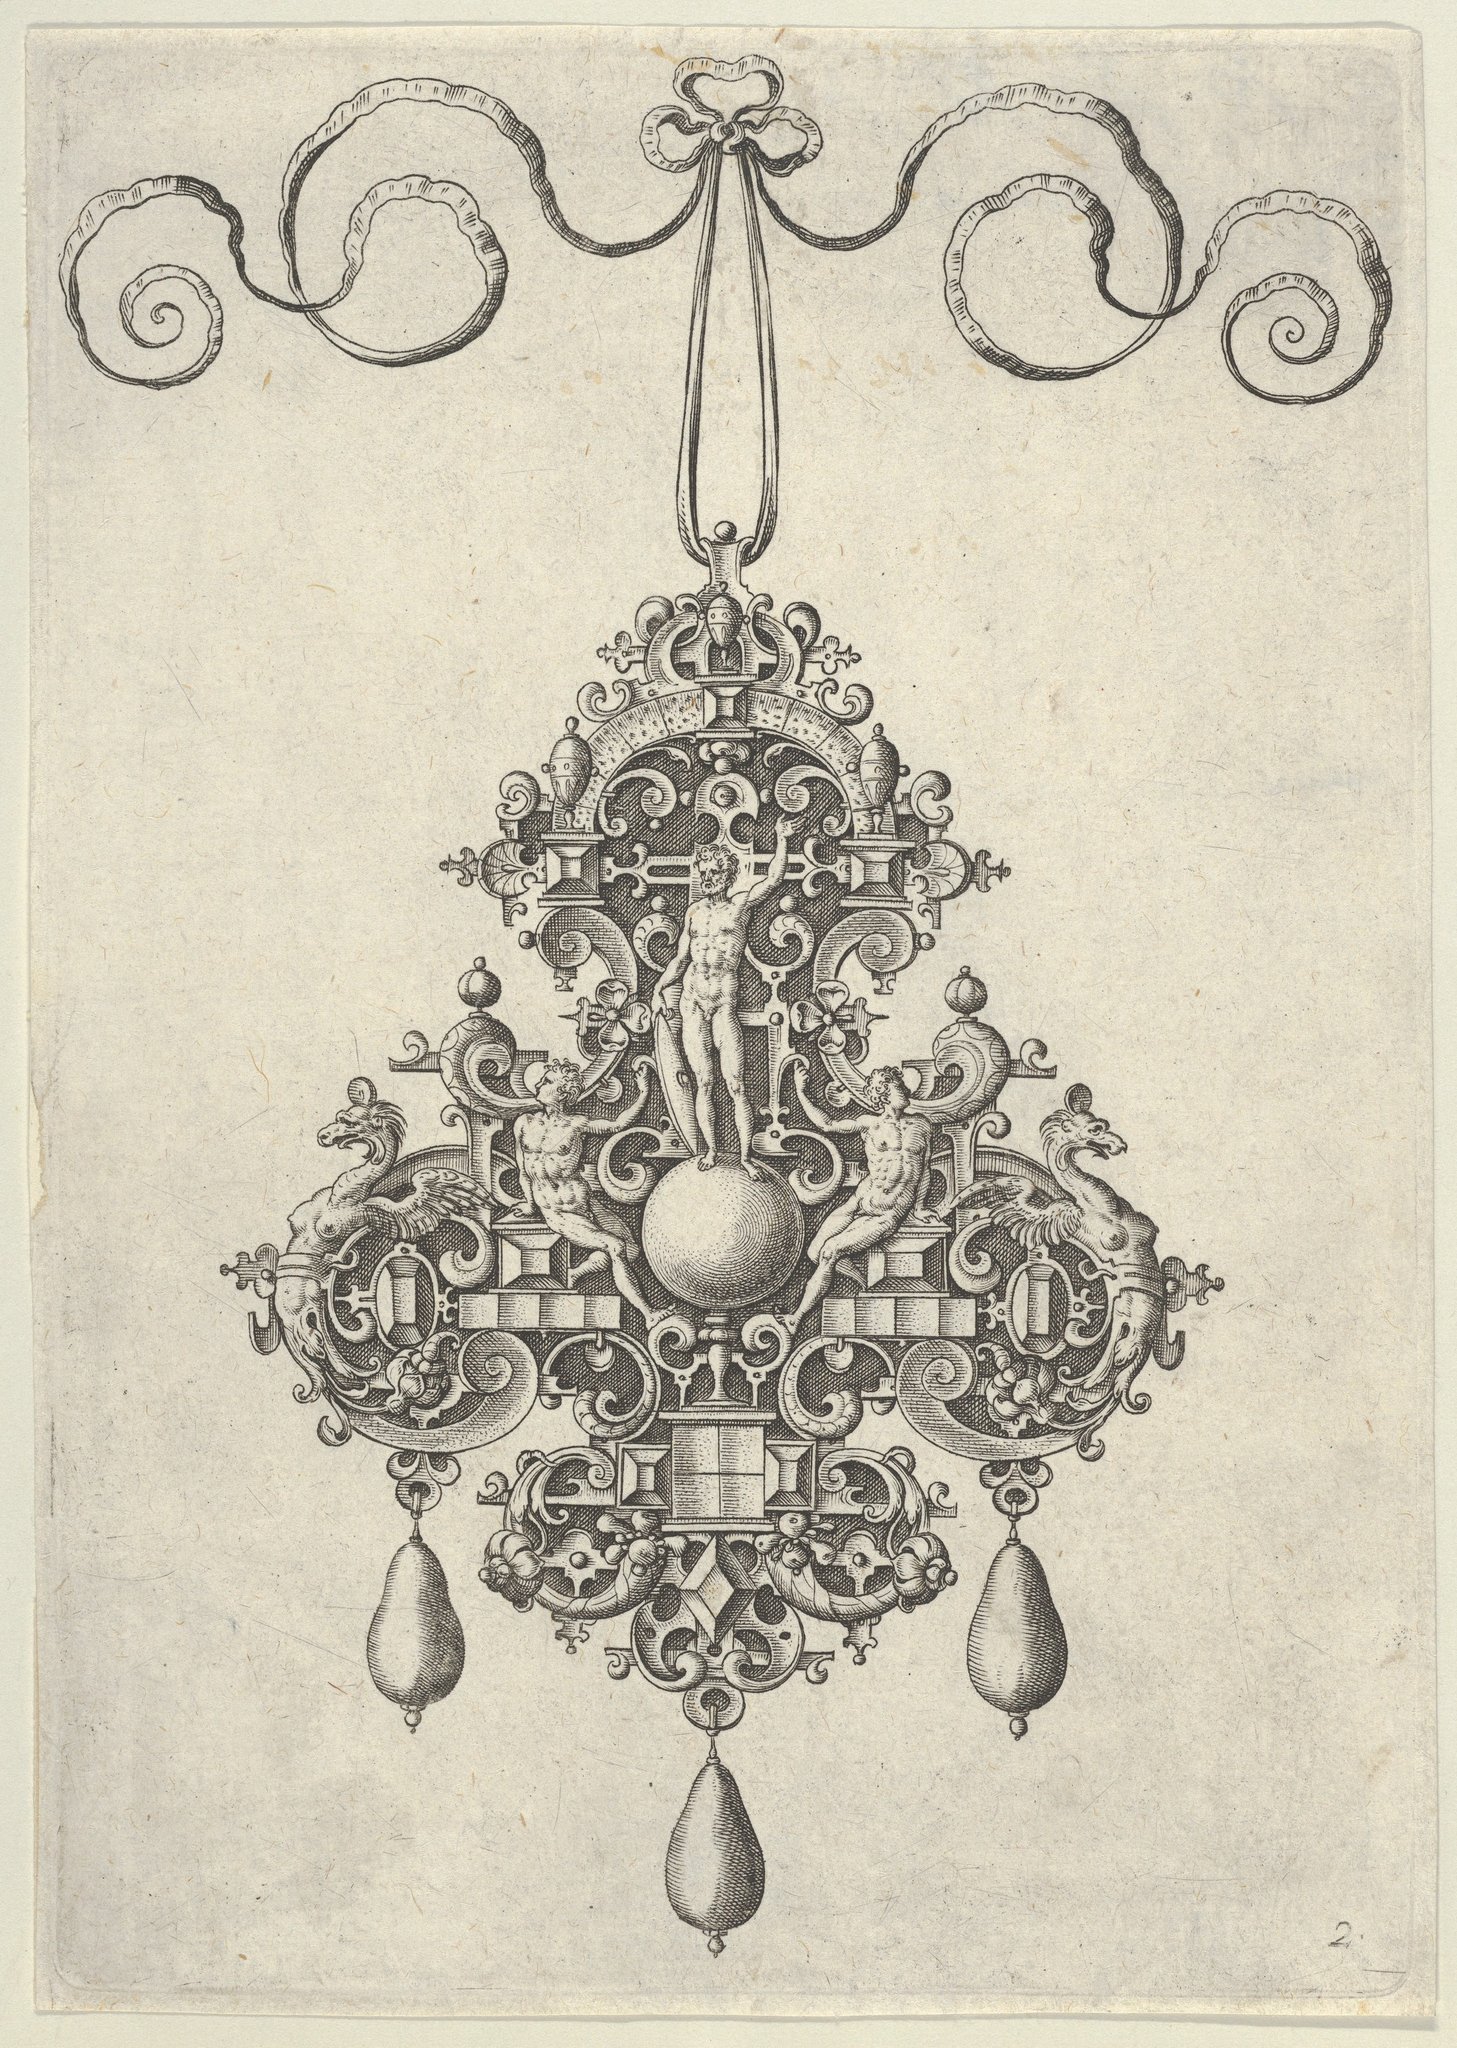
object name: print ornament architecture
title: Pendant Design with a Male Diety with a Shield Flanked by Two Reclining Men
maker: jan collaert i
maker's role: artist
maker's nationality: netherlandish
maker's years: 1530-1581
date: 1581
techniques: engraving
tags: pendants,male nudes